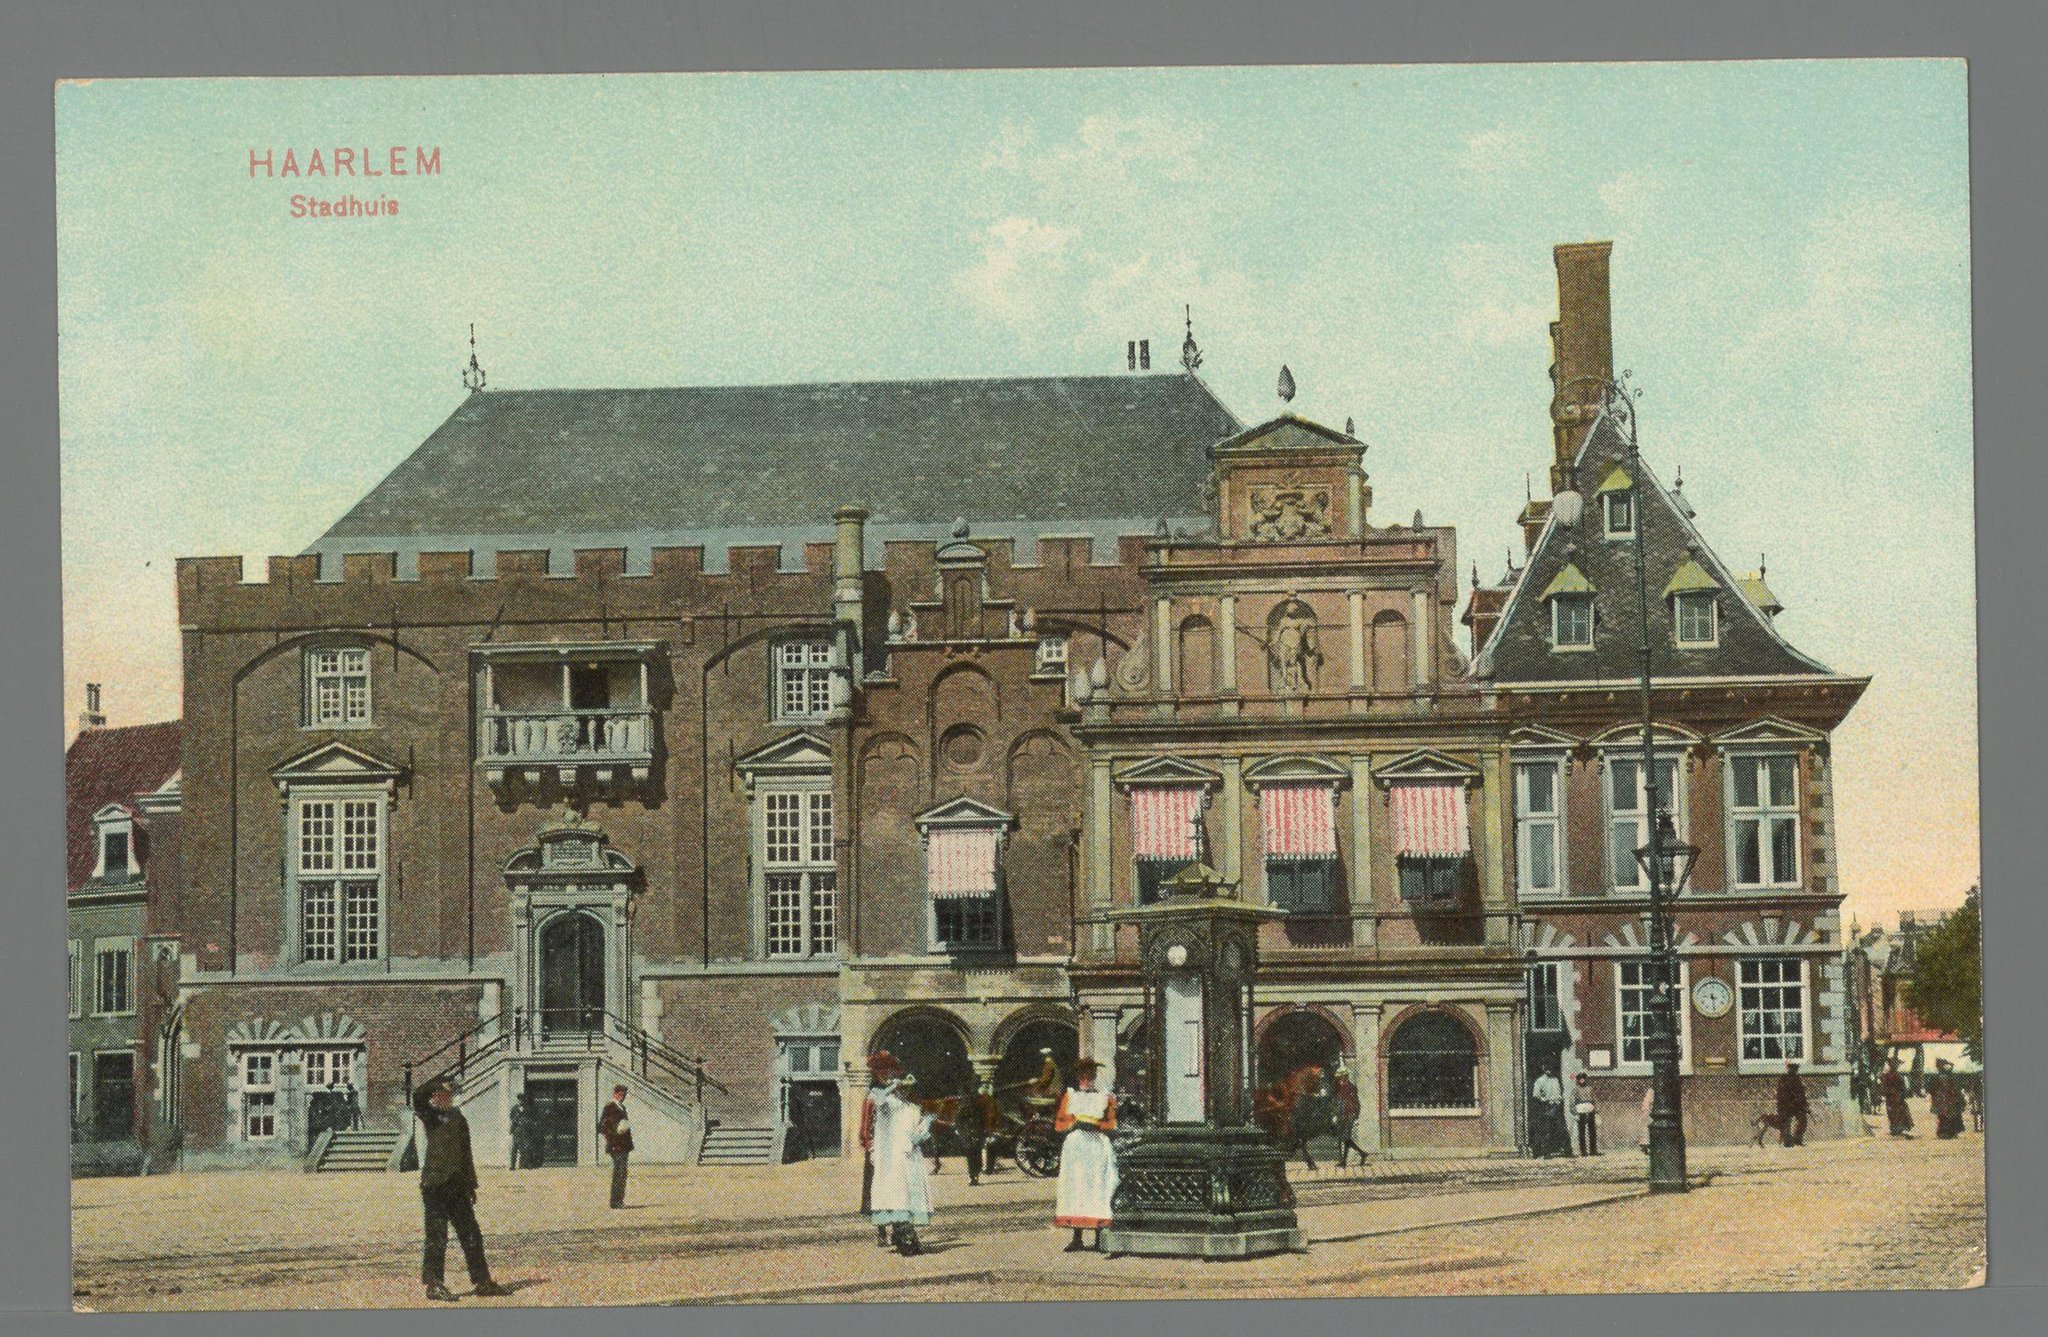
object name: ansichtkaart, prentbriefkaart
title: Haarlem. Stadhuis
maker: Anonymous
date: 1906-1930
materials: cardboard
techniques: autotype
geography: leipzig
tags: city-view, and landscape with man-made constructions, townhall, haarlem